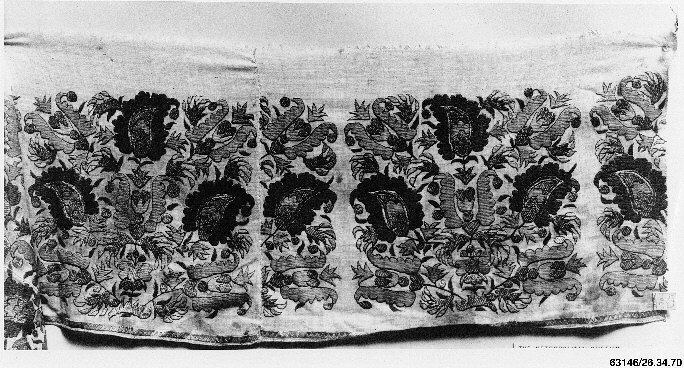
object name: border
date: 1701-1800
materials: linen, metal thread, silk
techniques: embroidery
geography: turkey